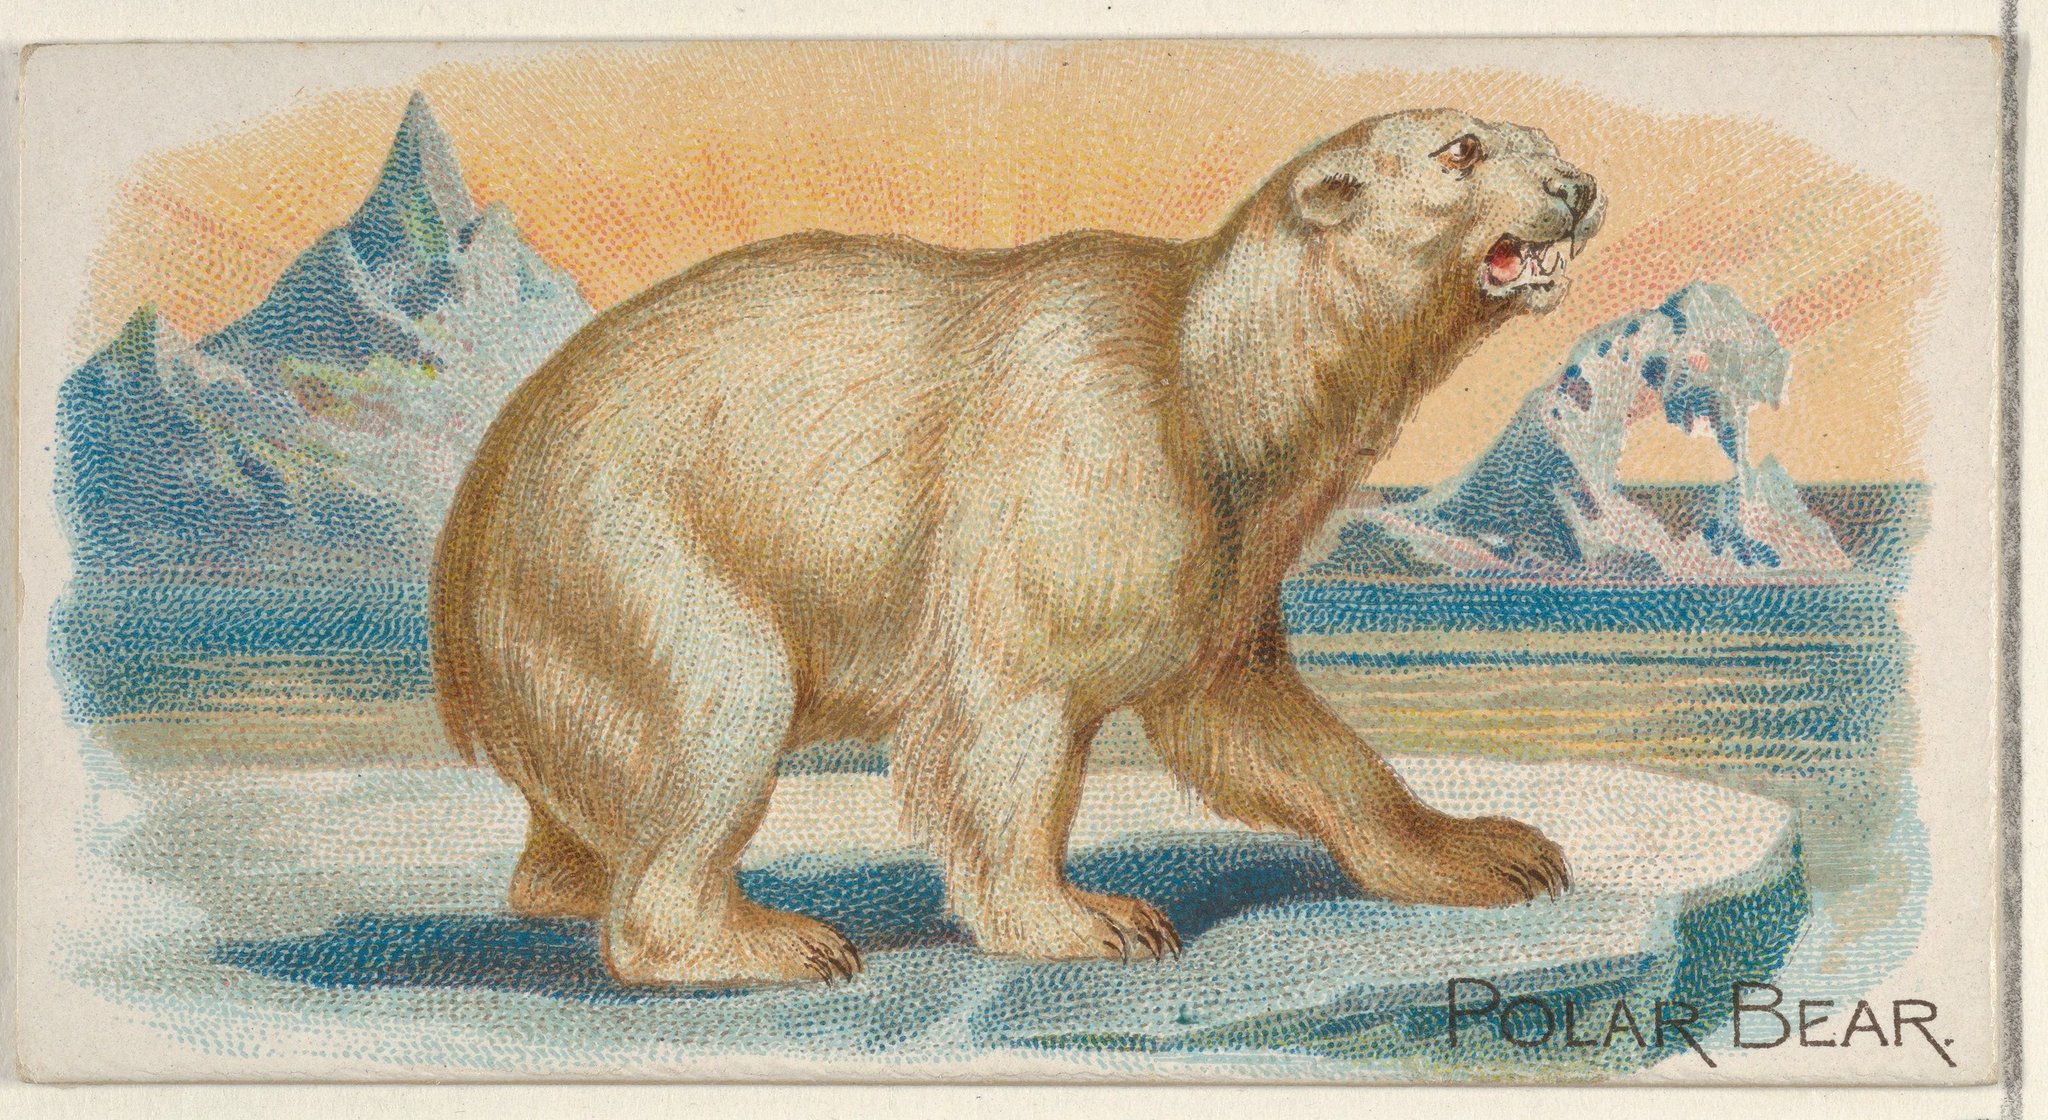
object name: print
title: Polar Bear, from the Quadrupeds series (N21) for Allen & Ginter Cigarettes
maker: allen & ginter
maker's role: publisher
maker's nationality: american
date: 1890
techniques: color lithograph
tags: bears